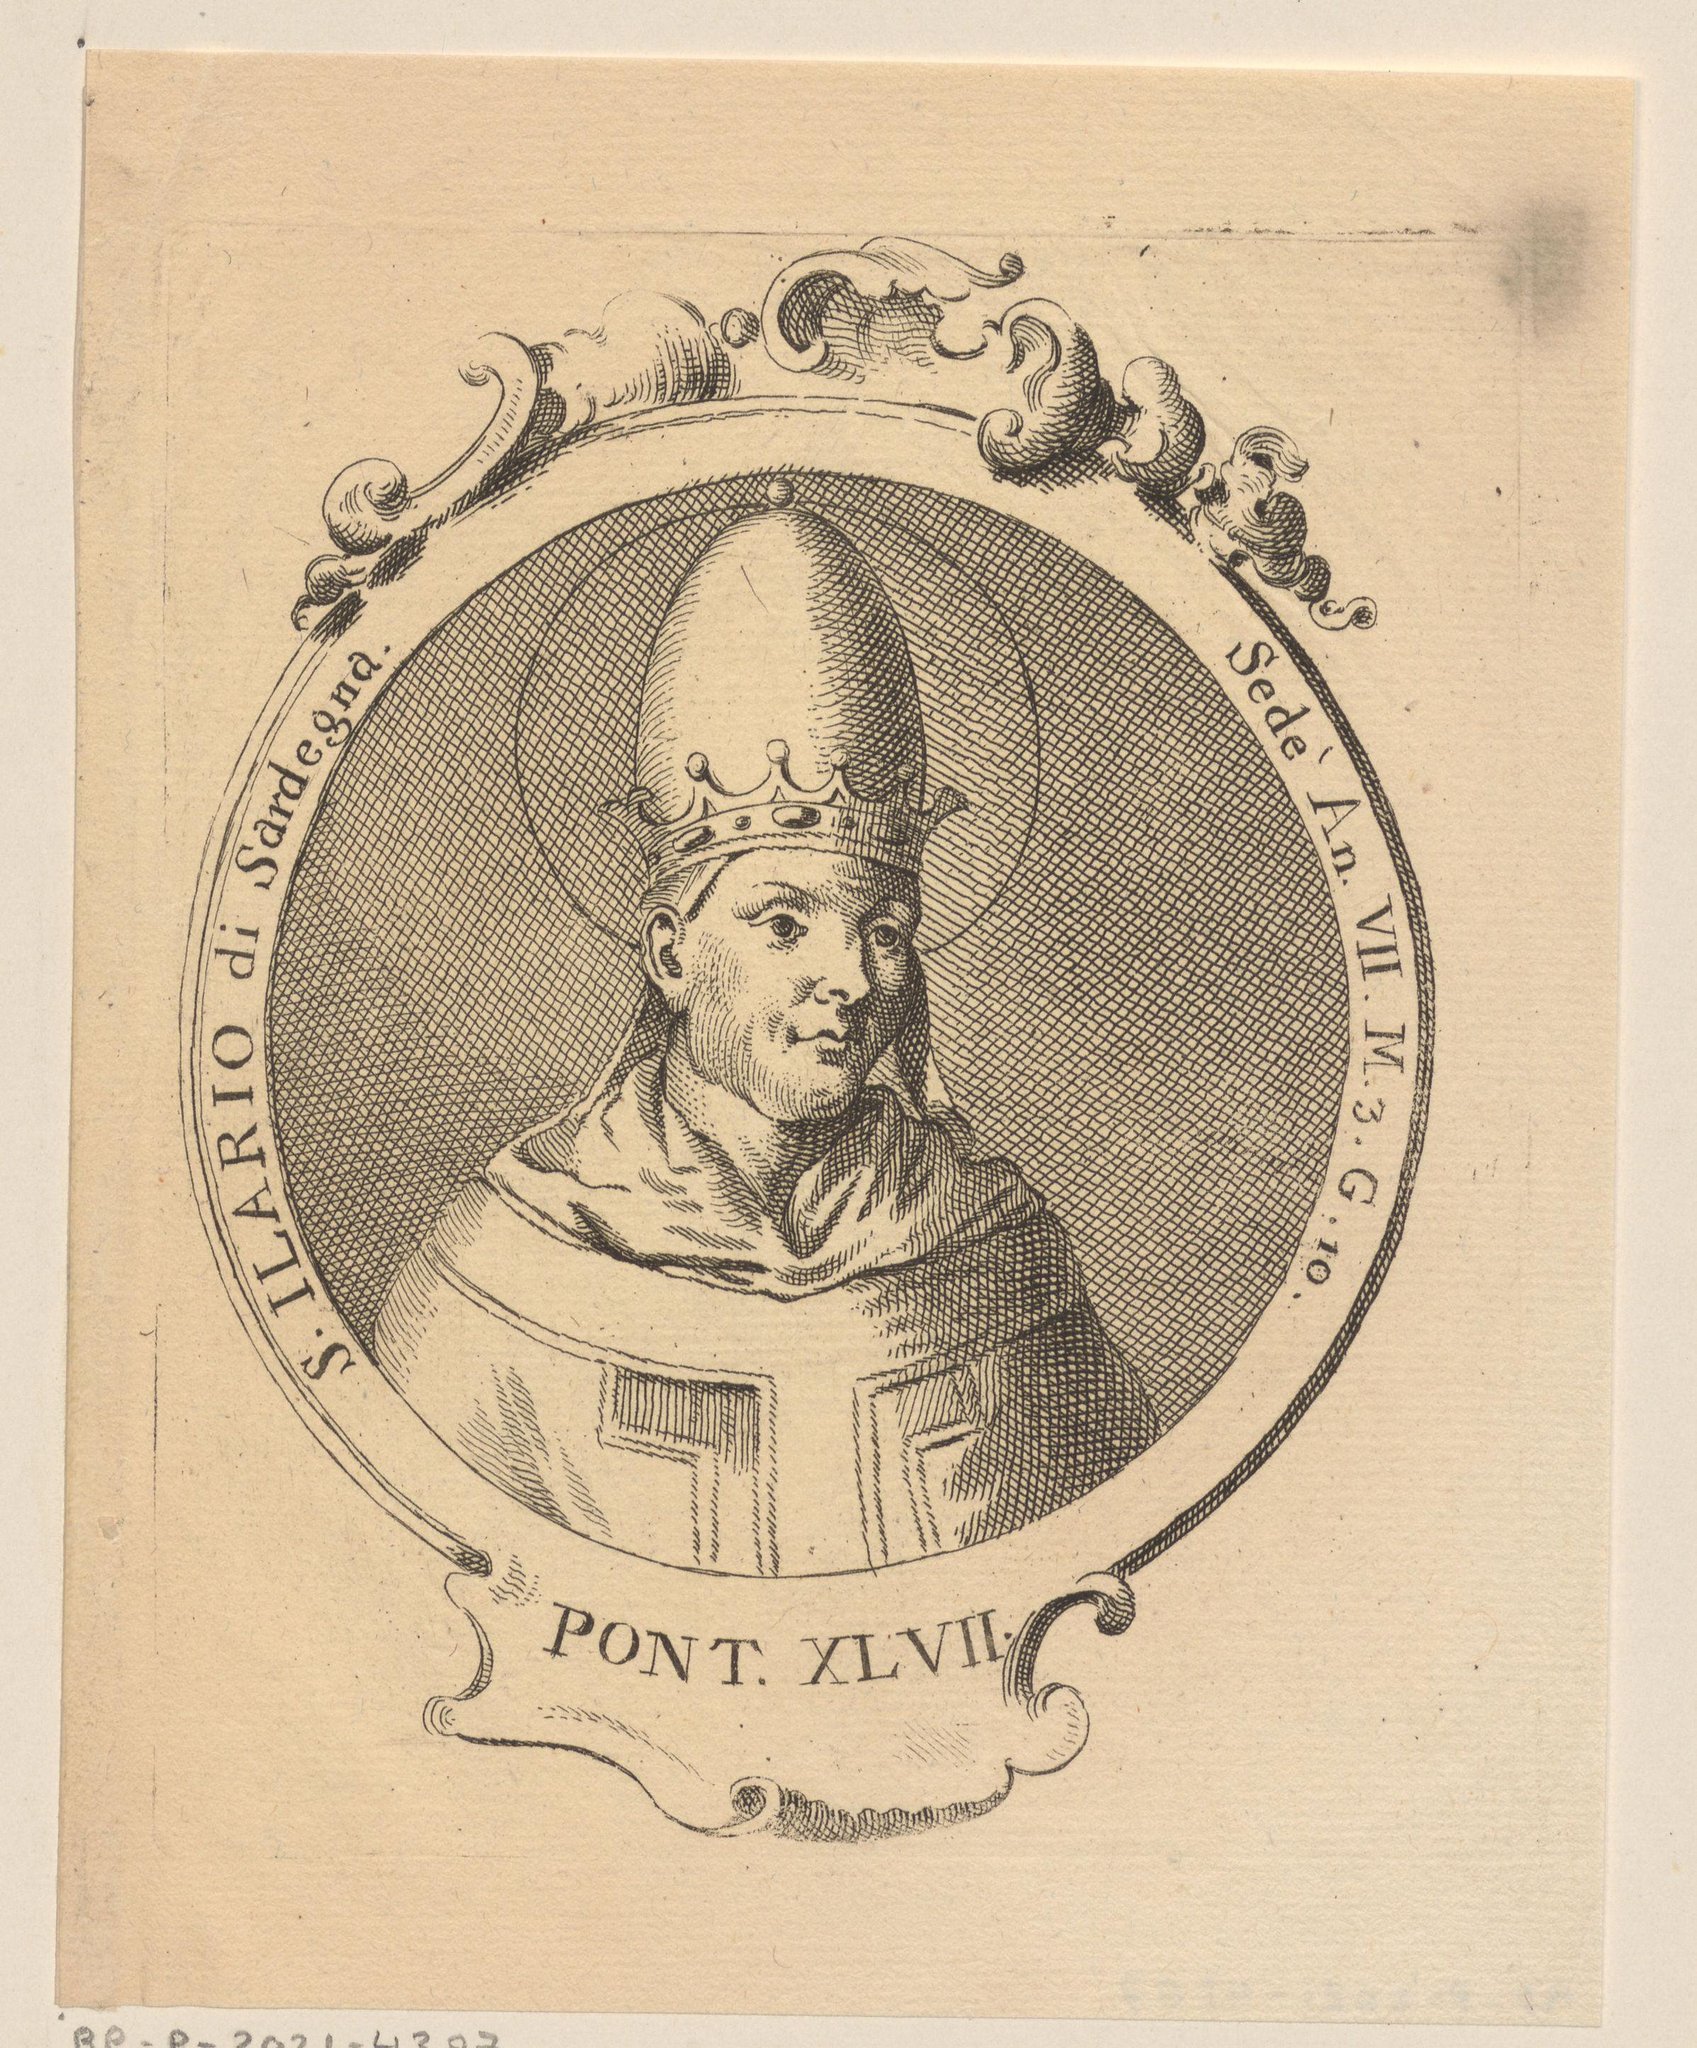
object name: book illustration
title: Portret van paus Hilarius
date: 1775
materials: paper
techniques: engraving, etching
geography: bassano del grappa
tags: rome, historical persons, pope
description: Prent uit: Effigies Romanorum pontificum a S. Petro ad Pium VI. feliciter regnantem (...). 2 dln. Venetië en Bassano del Grappa: Giuseppe Remondini, 1775.